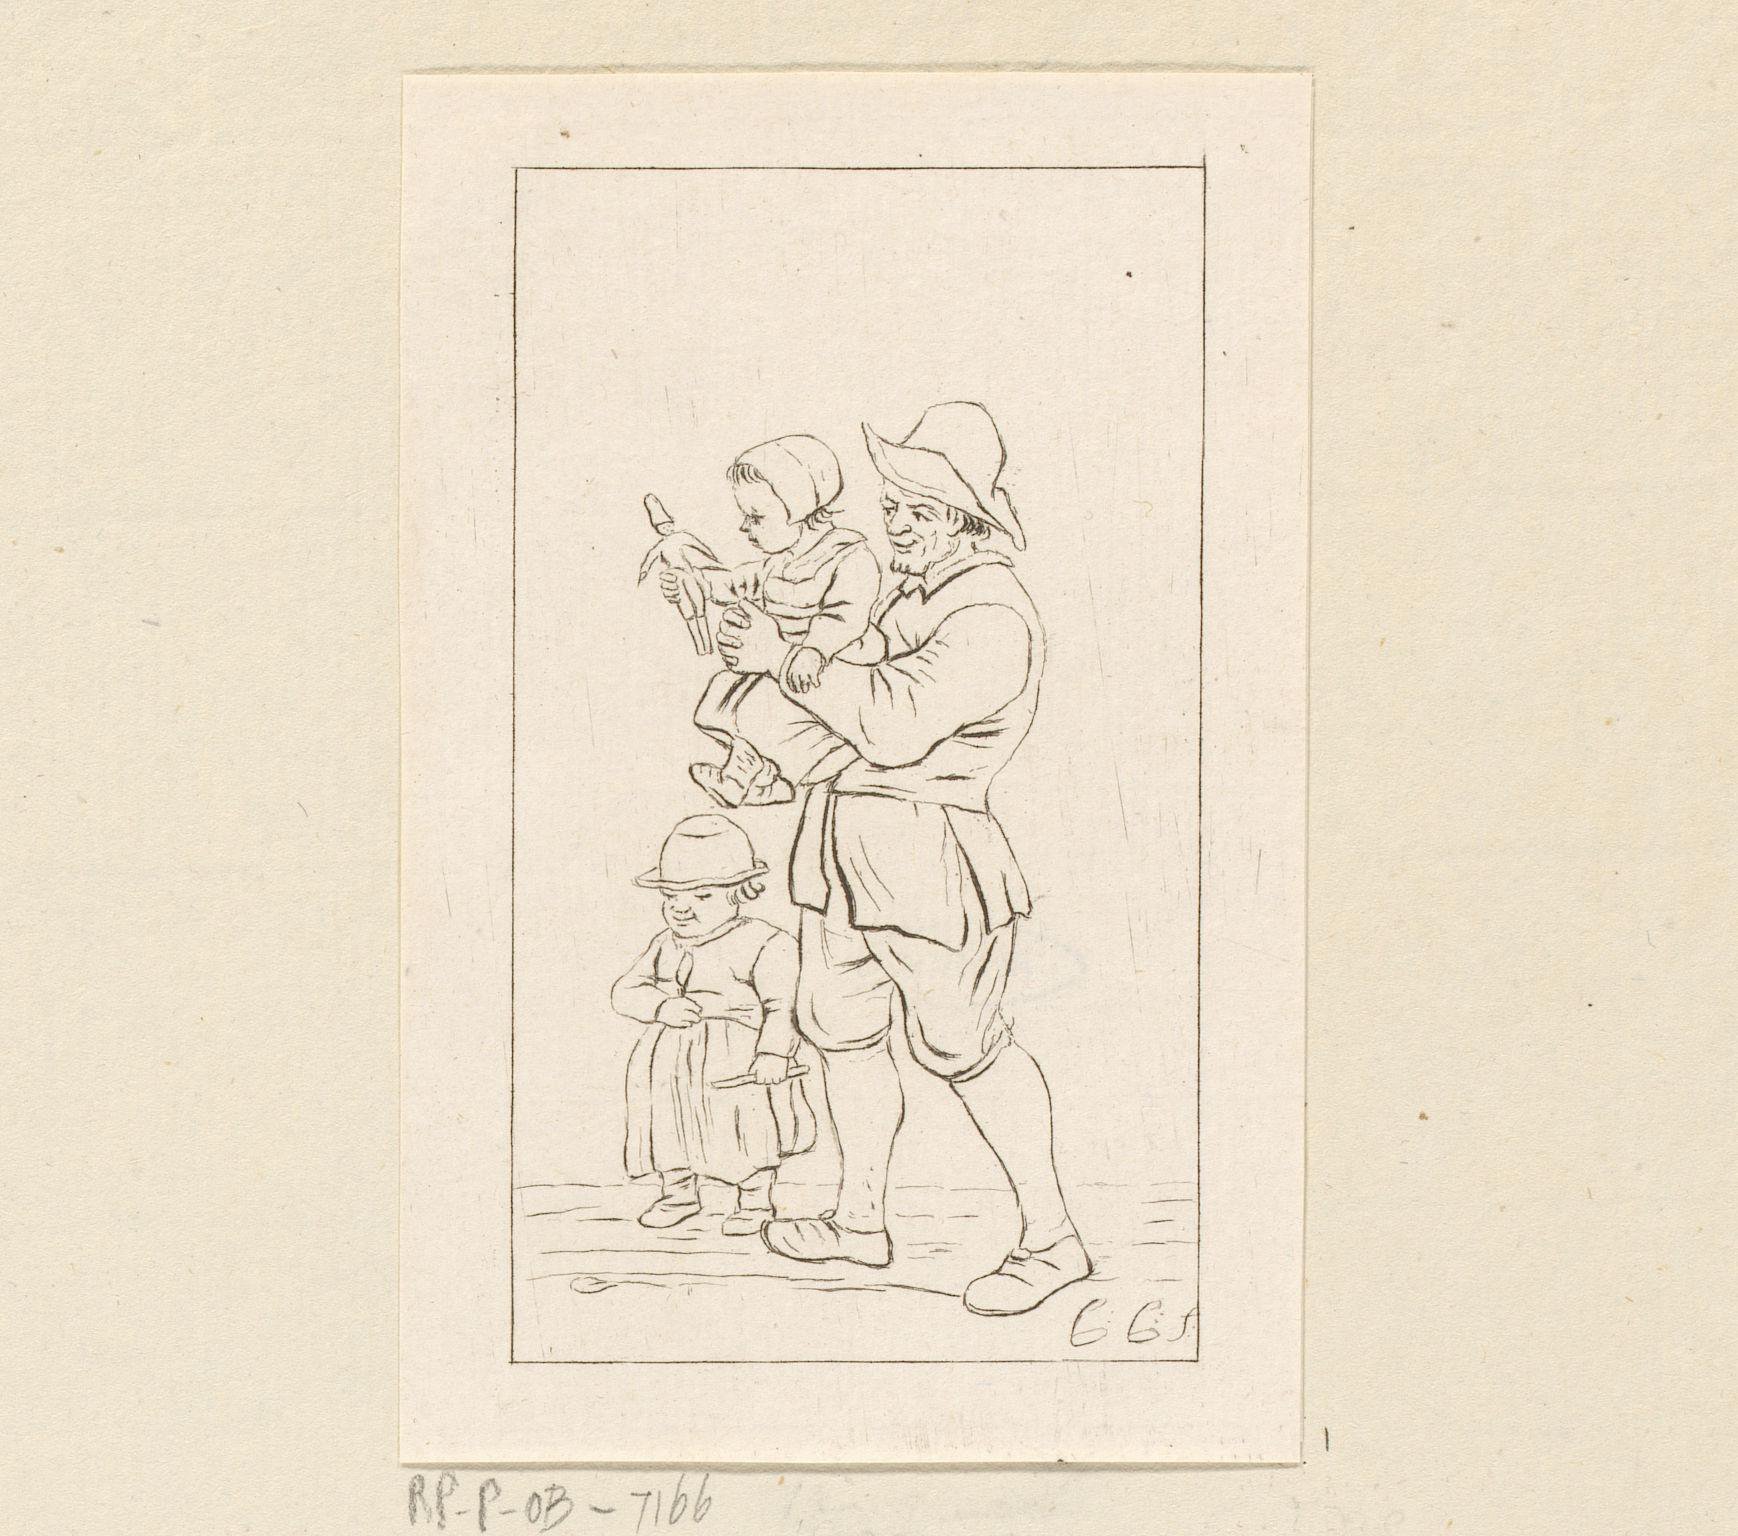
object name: print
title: Vader met twee kinderen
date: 1779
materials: paper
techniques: etching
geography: leiden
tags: father and child(ren), man and child(ren) (family group) (with number of children)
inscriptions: collector's mark: Lugt 2228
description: Een vader speelt met zijn twee kinderen. Een van de kinderen staat naast de man terwijl het andere wordt opgepakt door haar vader.